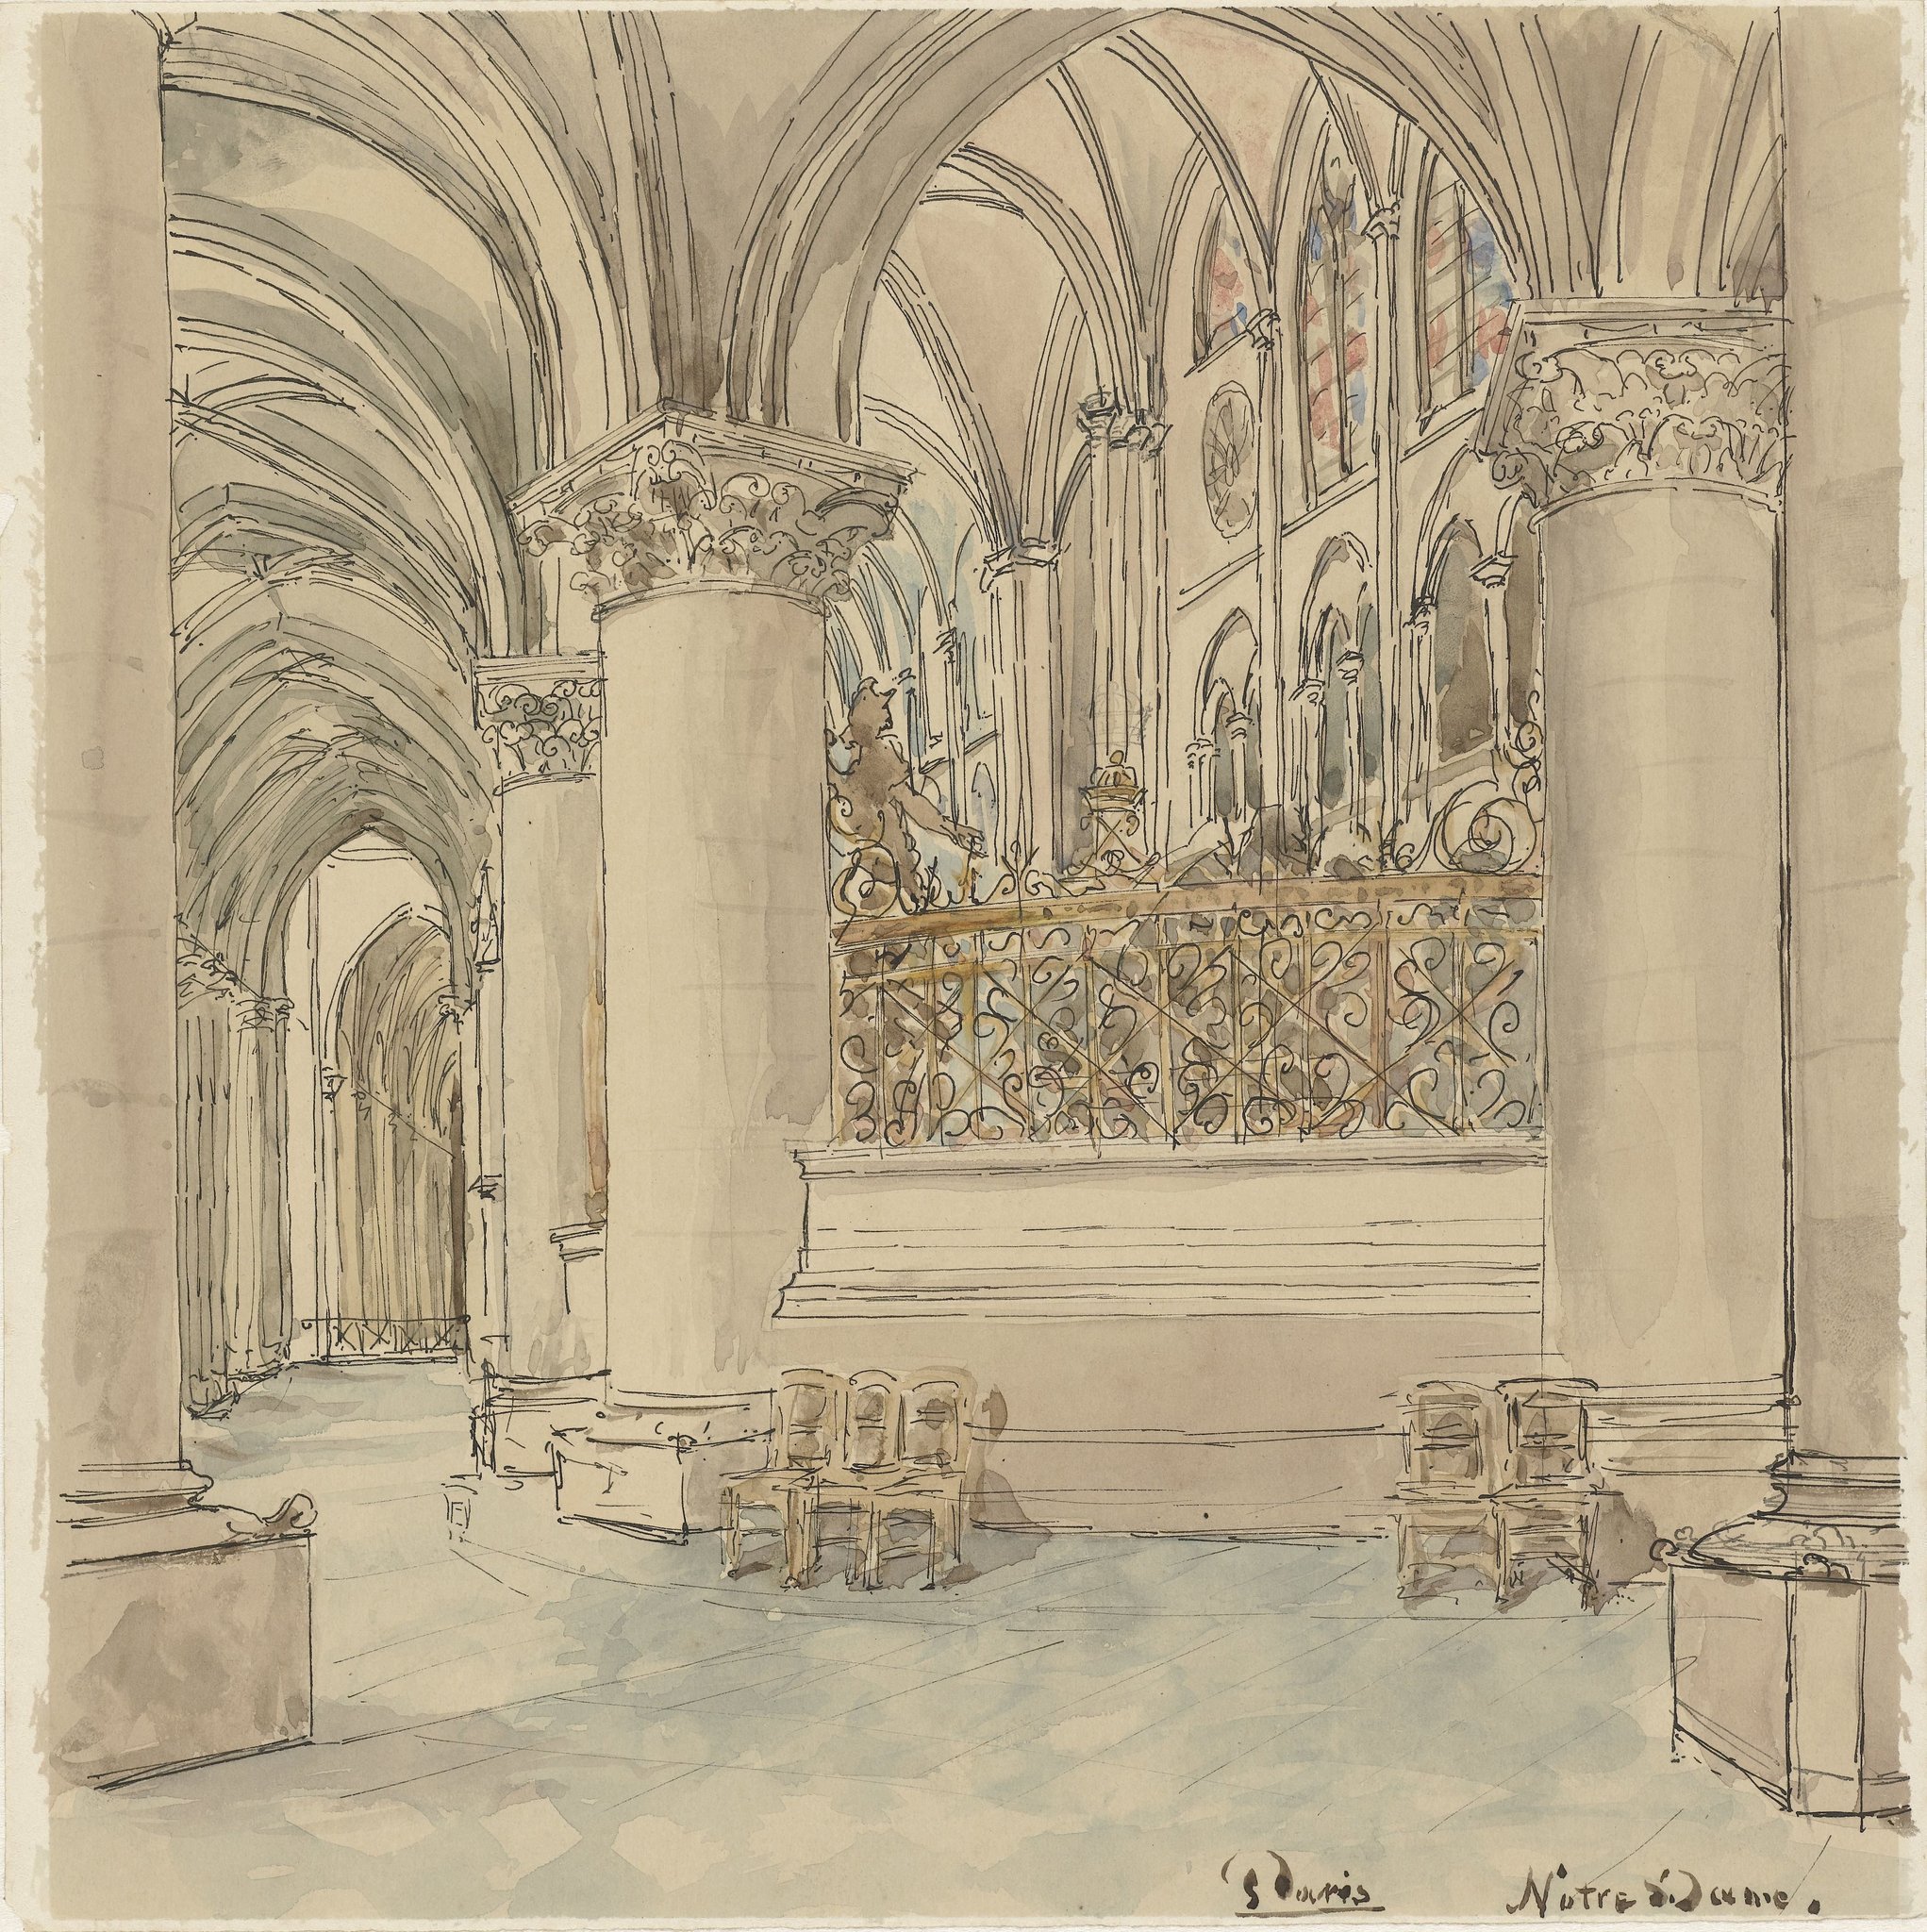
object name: drawing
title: Interieur van de Notre-Dame te Parijs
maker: wilhelm cornelis bauer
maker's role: draughtsman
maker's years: 1862-1904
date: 1872-1904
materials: ink, paper, pencil, watercolor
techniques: brush, pen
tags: interior of church